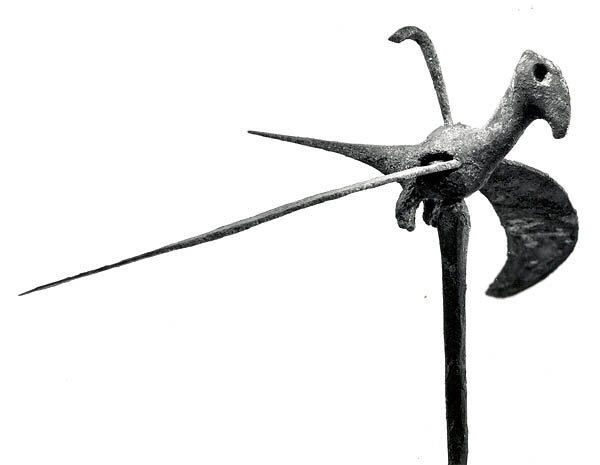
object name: sculpture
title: Bird standard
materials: copper alloy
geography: southeastern iran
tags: birds